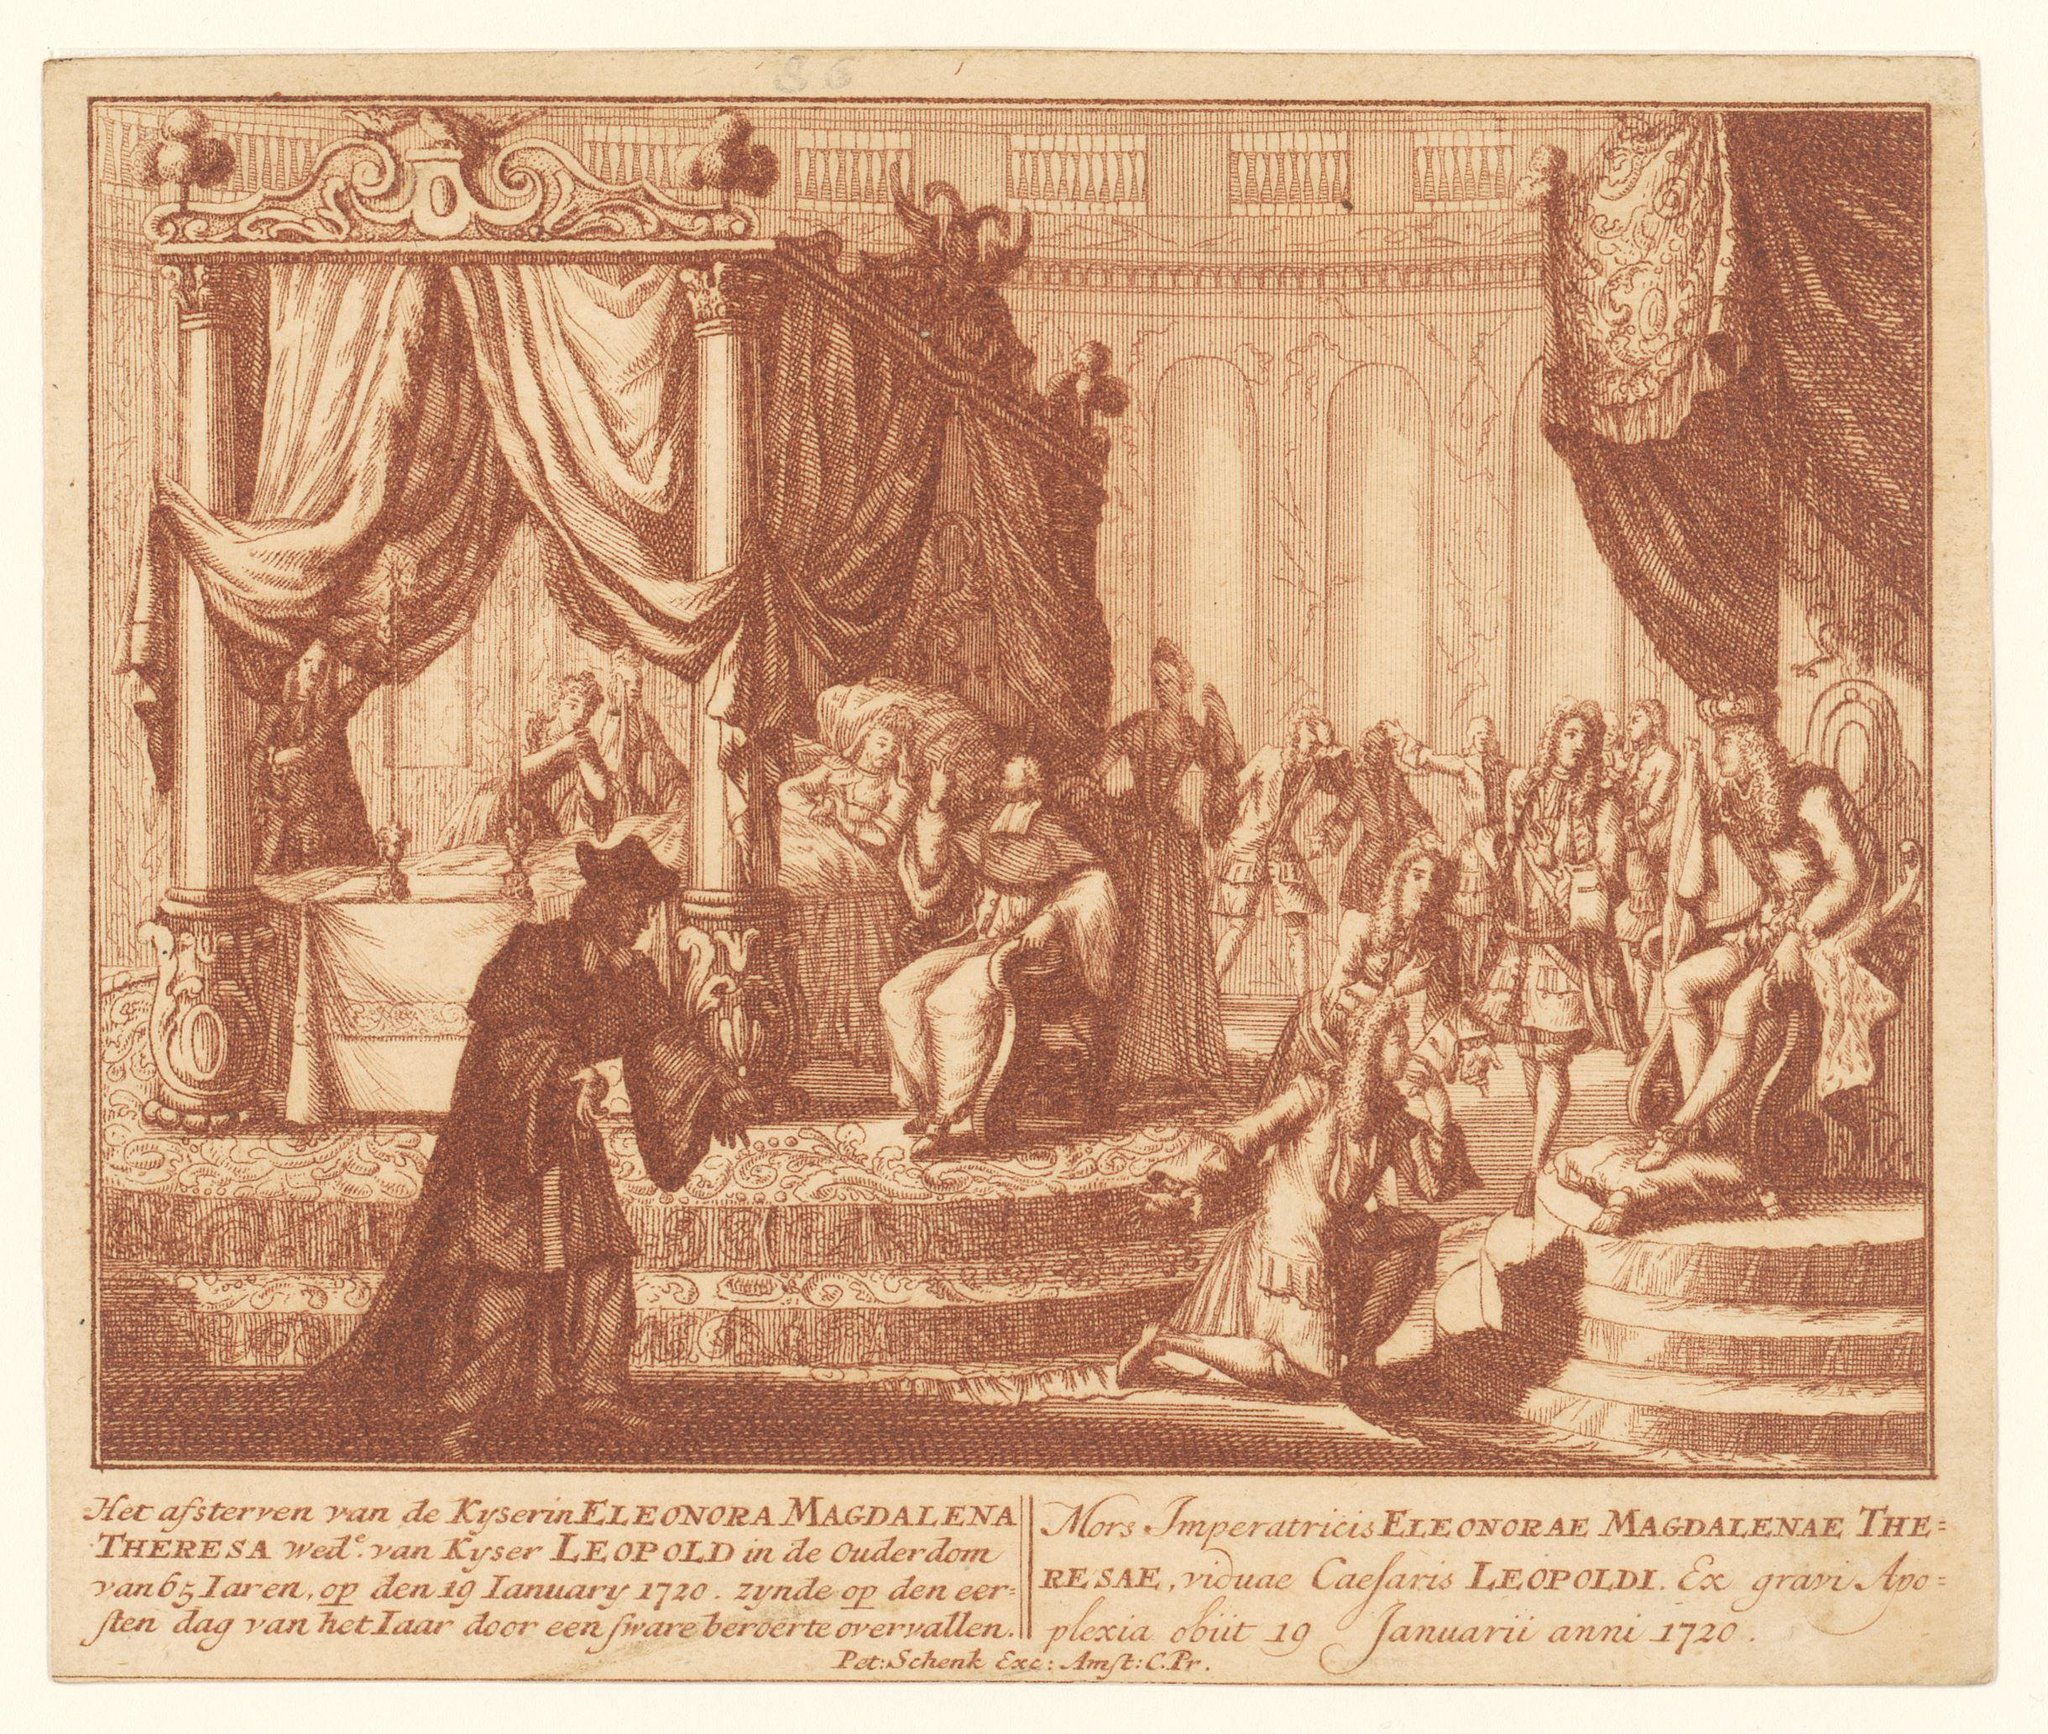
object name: print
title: Het afsterven van de Kyserin Eleonora Magdalena Theresa wede. van Kyser Leopold in de Ouderdom van 65 Iaren (...)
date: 1720-1722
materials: paper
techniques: etching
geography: netherlands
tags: historical persons - bb - woman, queen, empress, etc. (wife of a ruler), deathbed